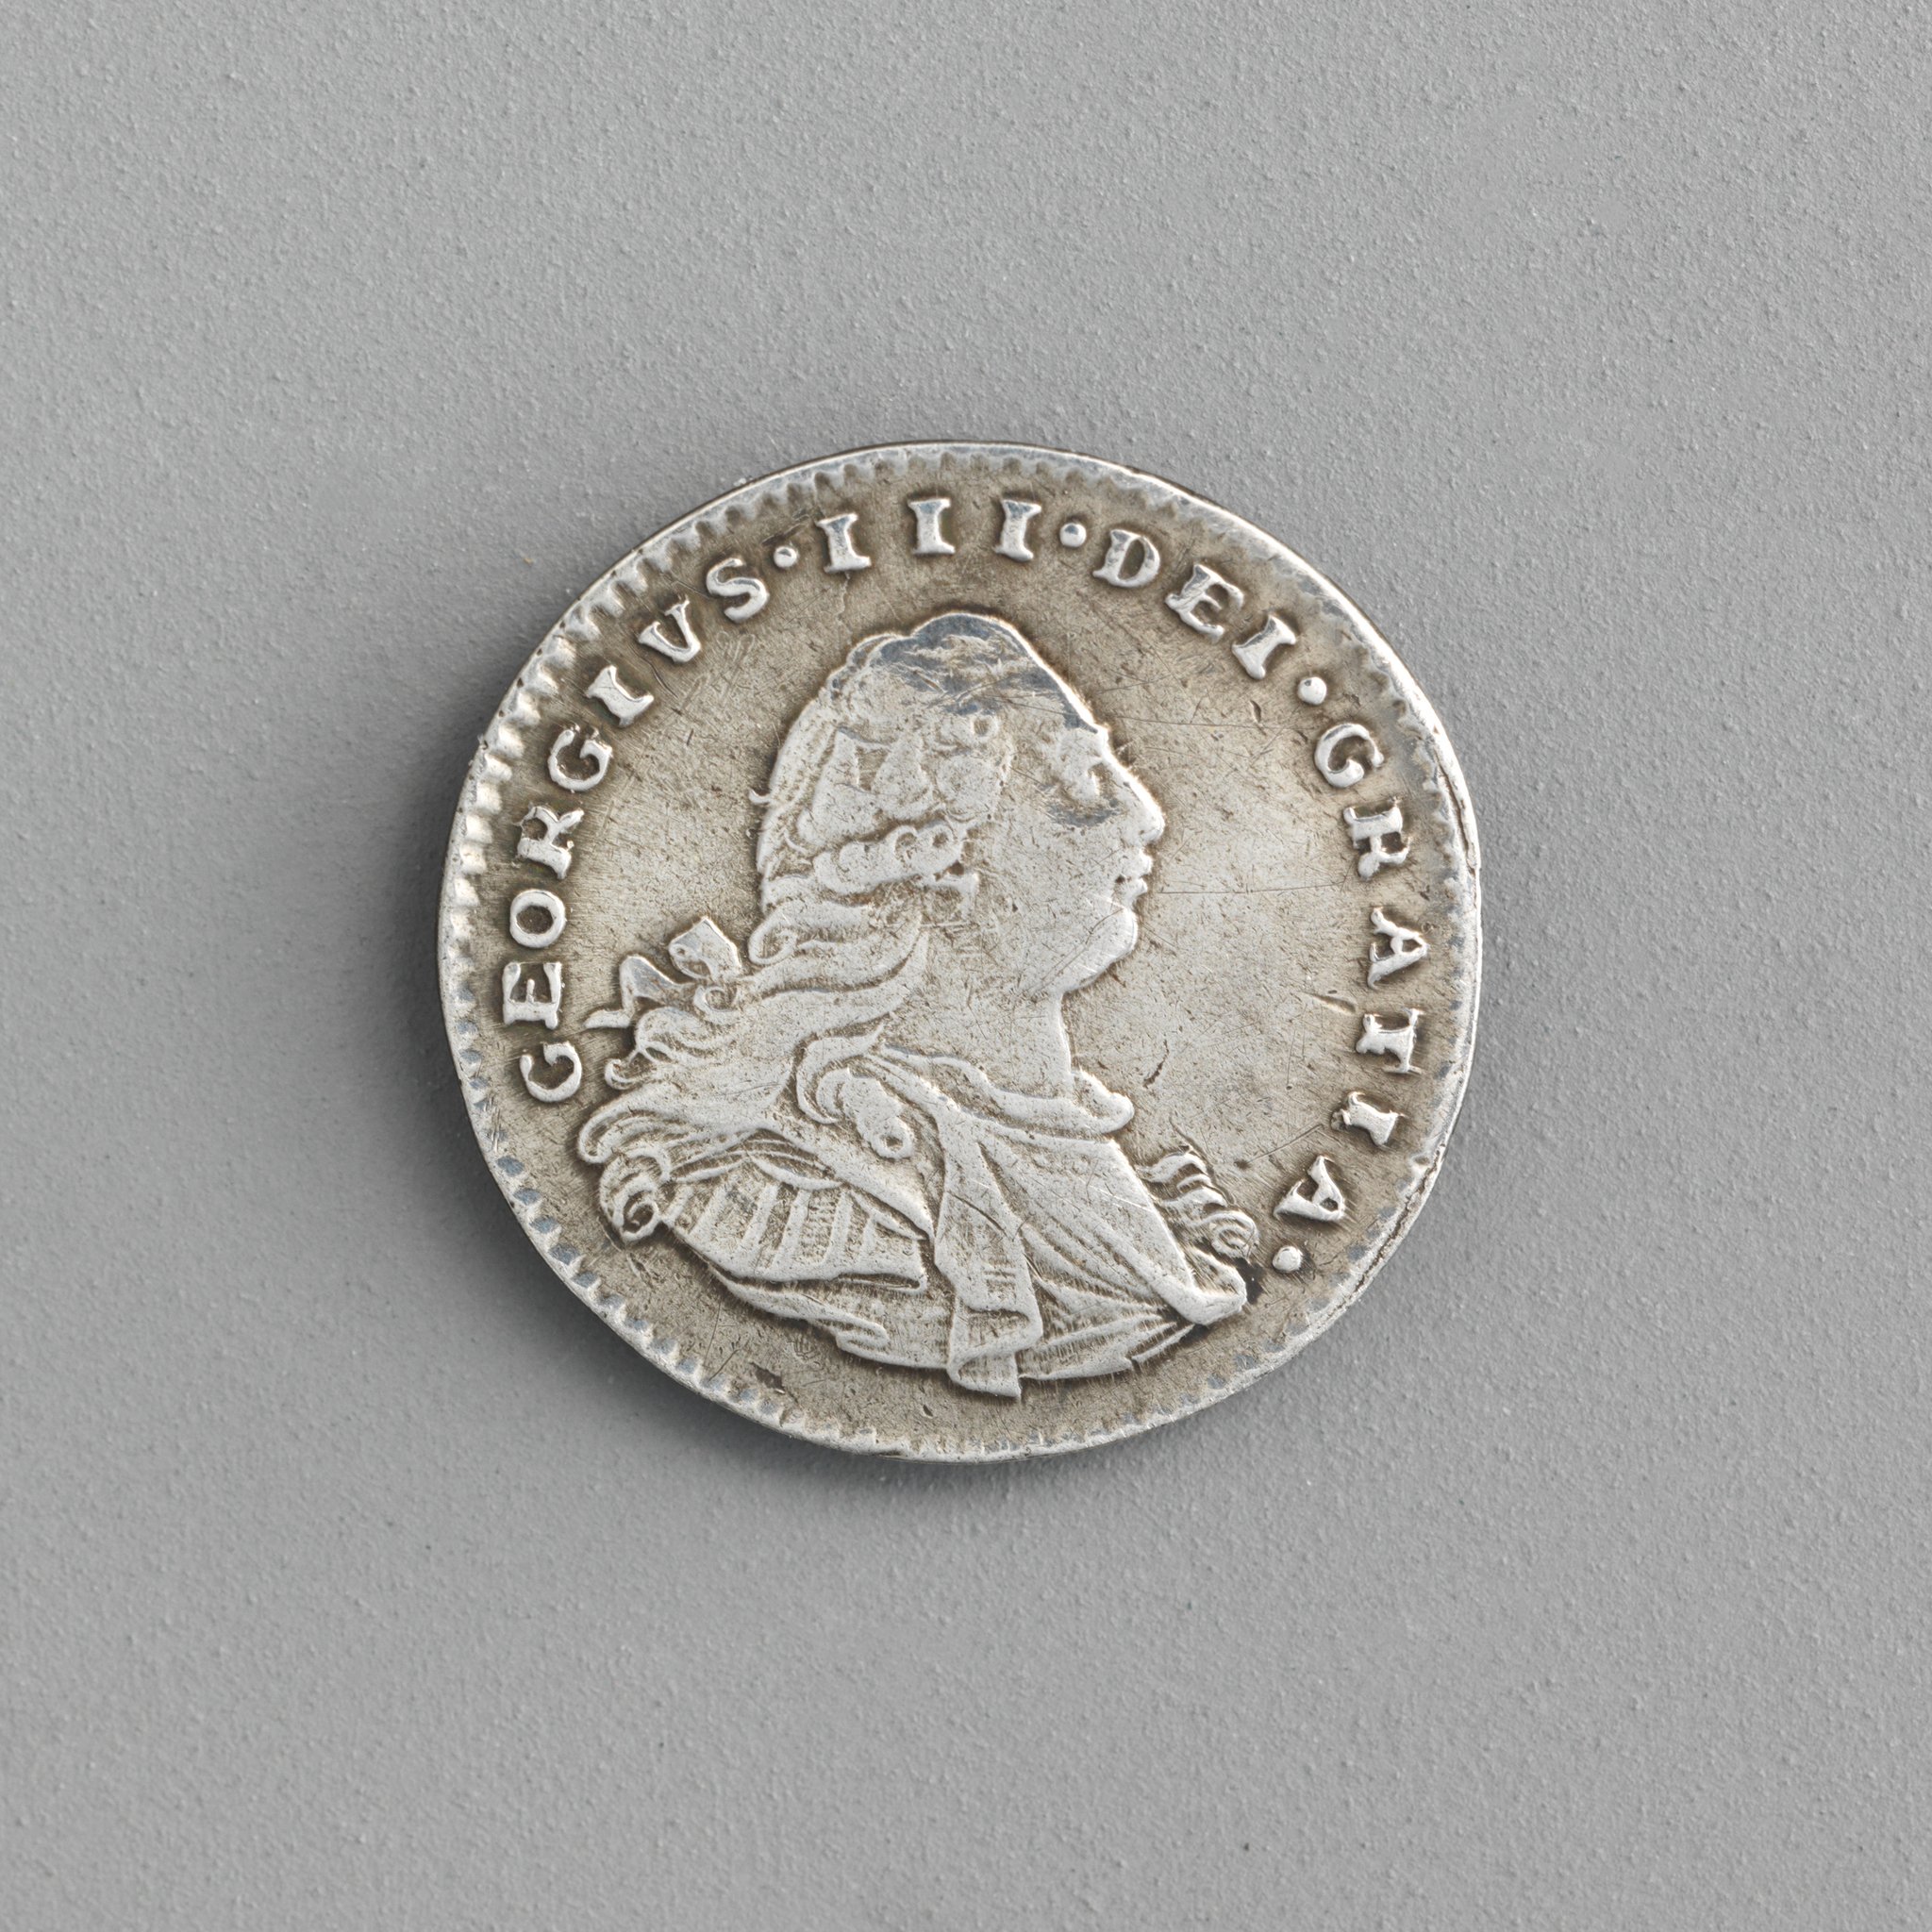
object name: penny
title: King George III of England, 1800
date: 1800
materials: silver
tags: men,profiles